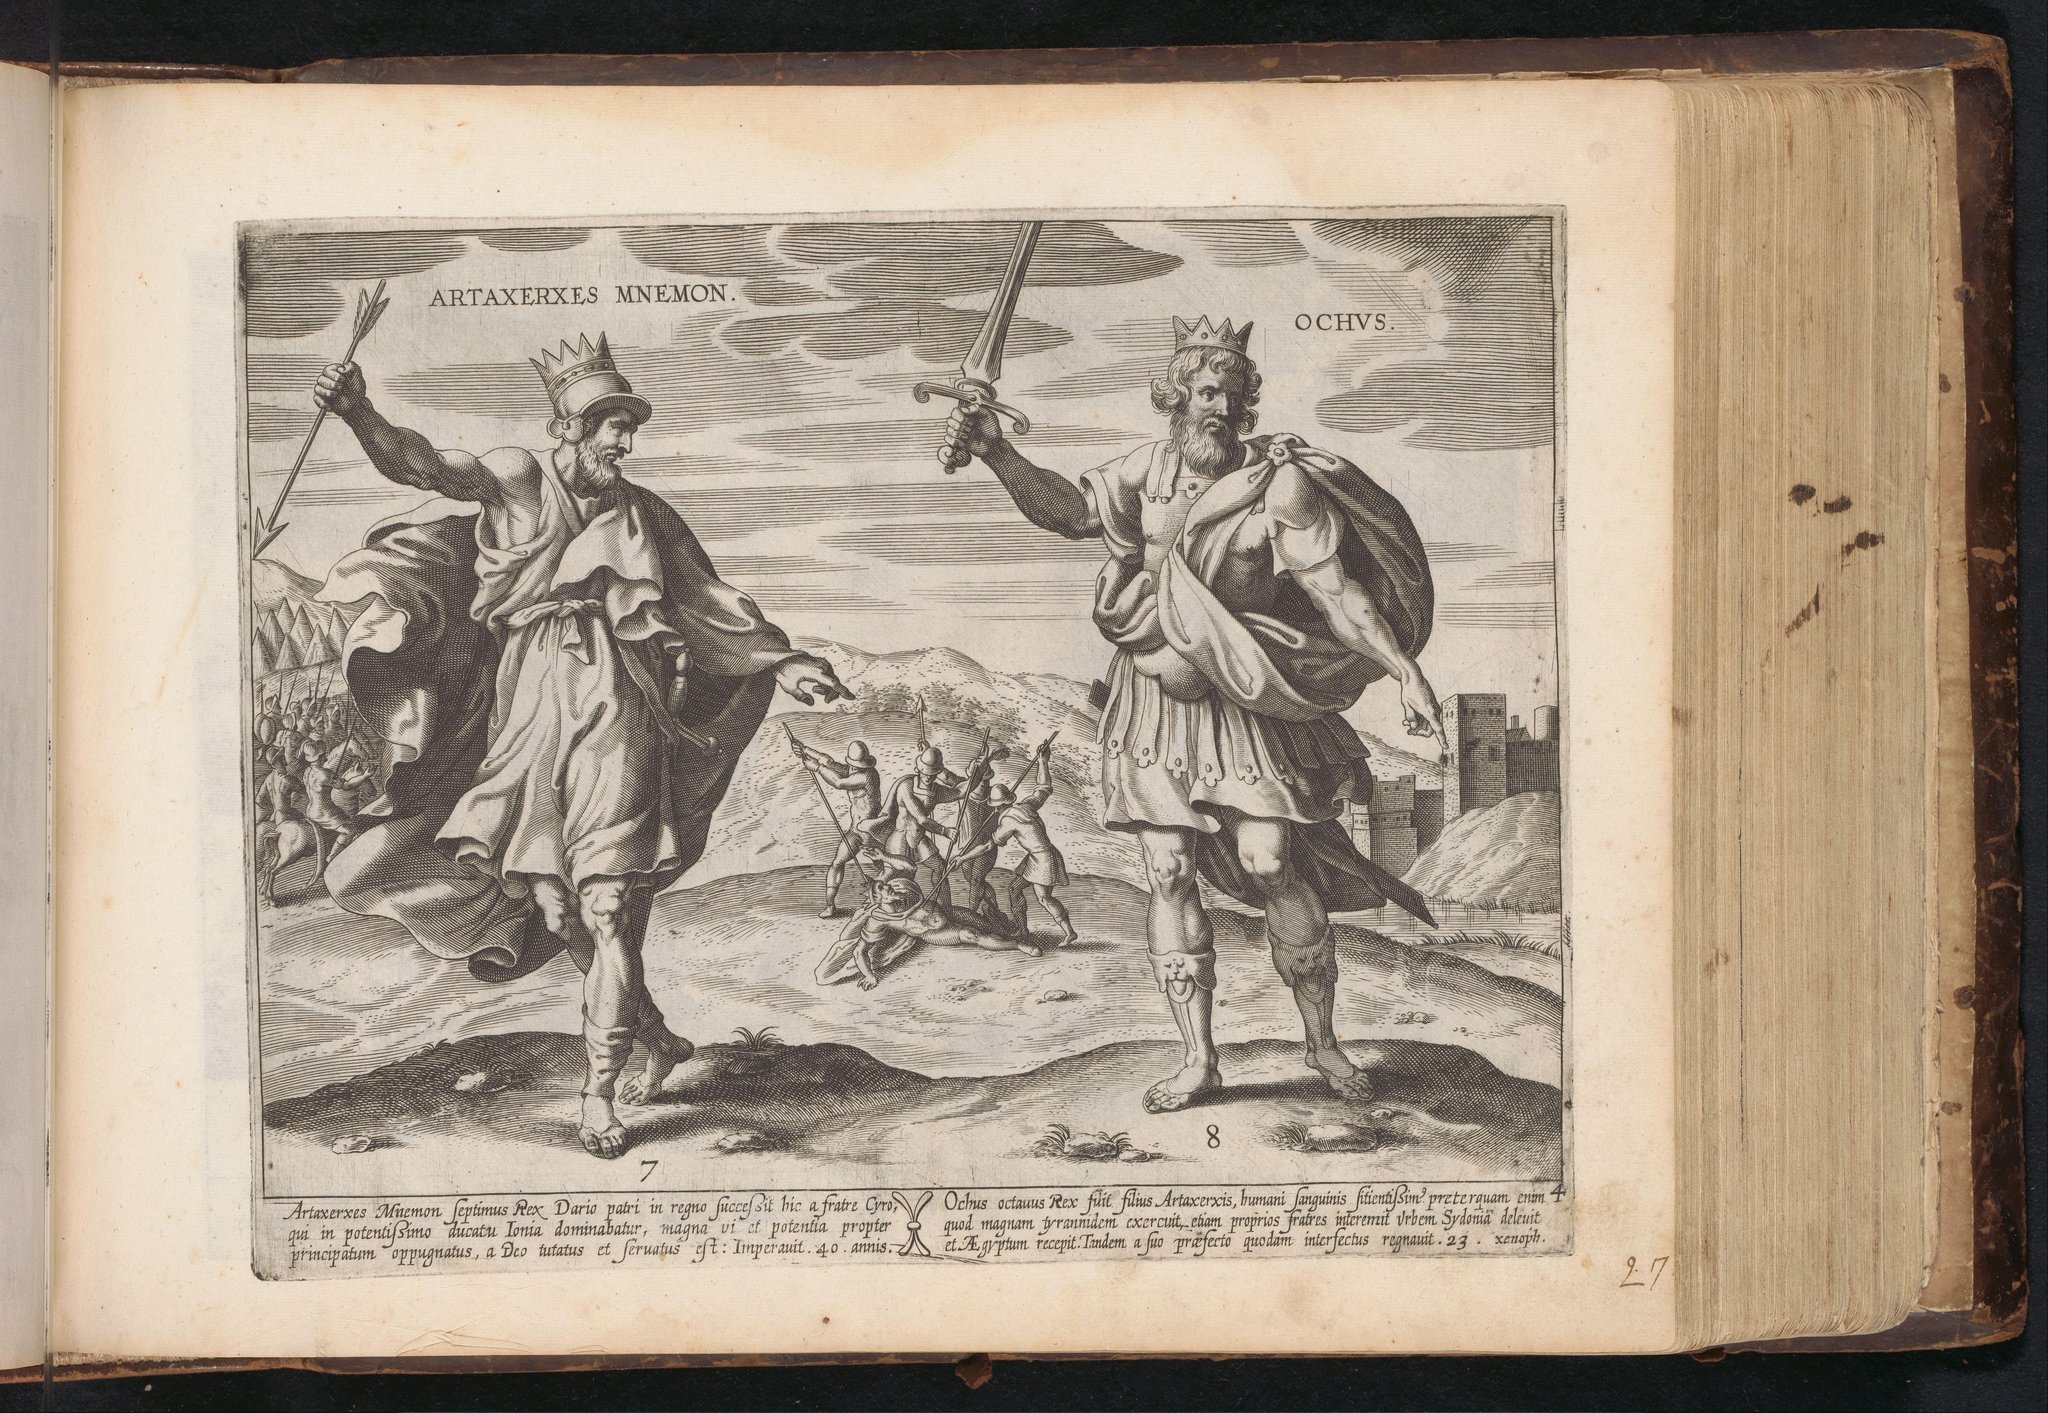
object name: album leaf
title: Van de Coningen van Persen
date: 1643-1646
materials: paper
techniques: engraving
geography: alkmaar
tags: battle, murder, male persons from classical history, ruler, sovereign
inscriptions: number: ‘27[4]’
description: Links koning Artaxerxes II van Perzië staande met een pijl in zijn hand. Op de achtergrond is te zien hoe Artaxerxes zijn jongere broer Cyrus verslaat, die tegen hem in opstand was gekomen. Rechts koning Artaxerxes III van Perzië staande met een zwaard in zijn hand. Op de achtergrond is vermoedelijk te zien hoe zijn oudere broer wordt geëxecuteerd. Onder de voorstelling verklarende teksten in het Latijn. Deze prent maakt deel uit van een album.